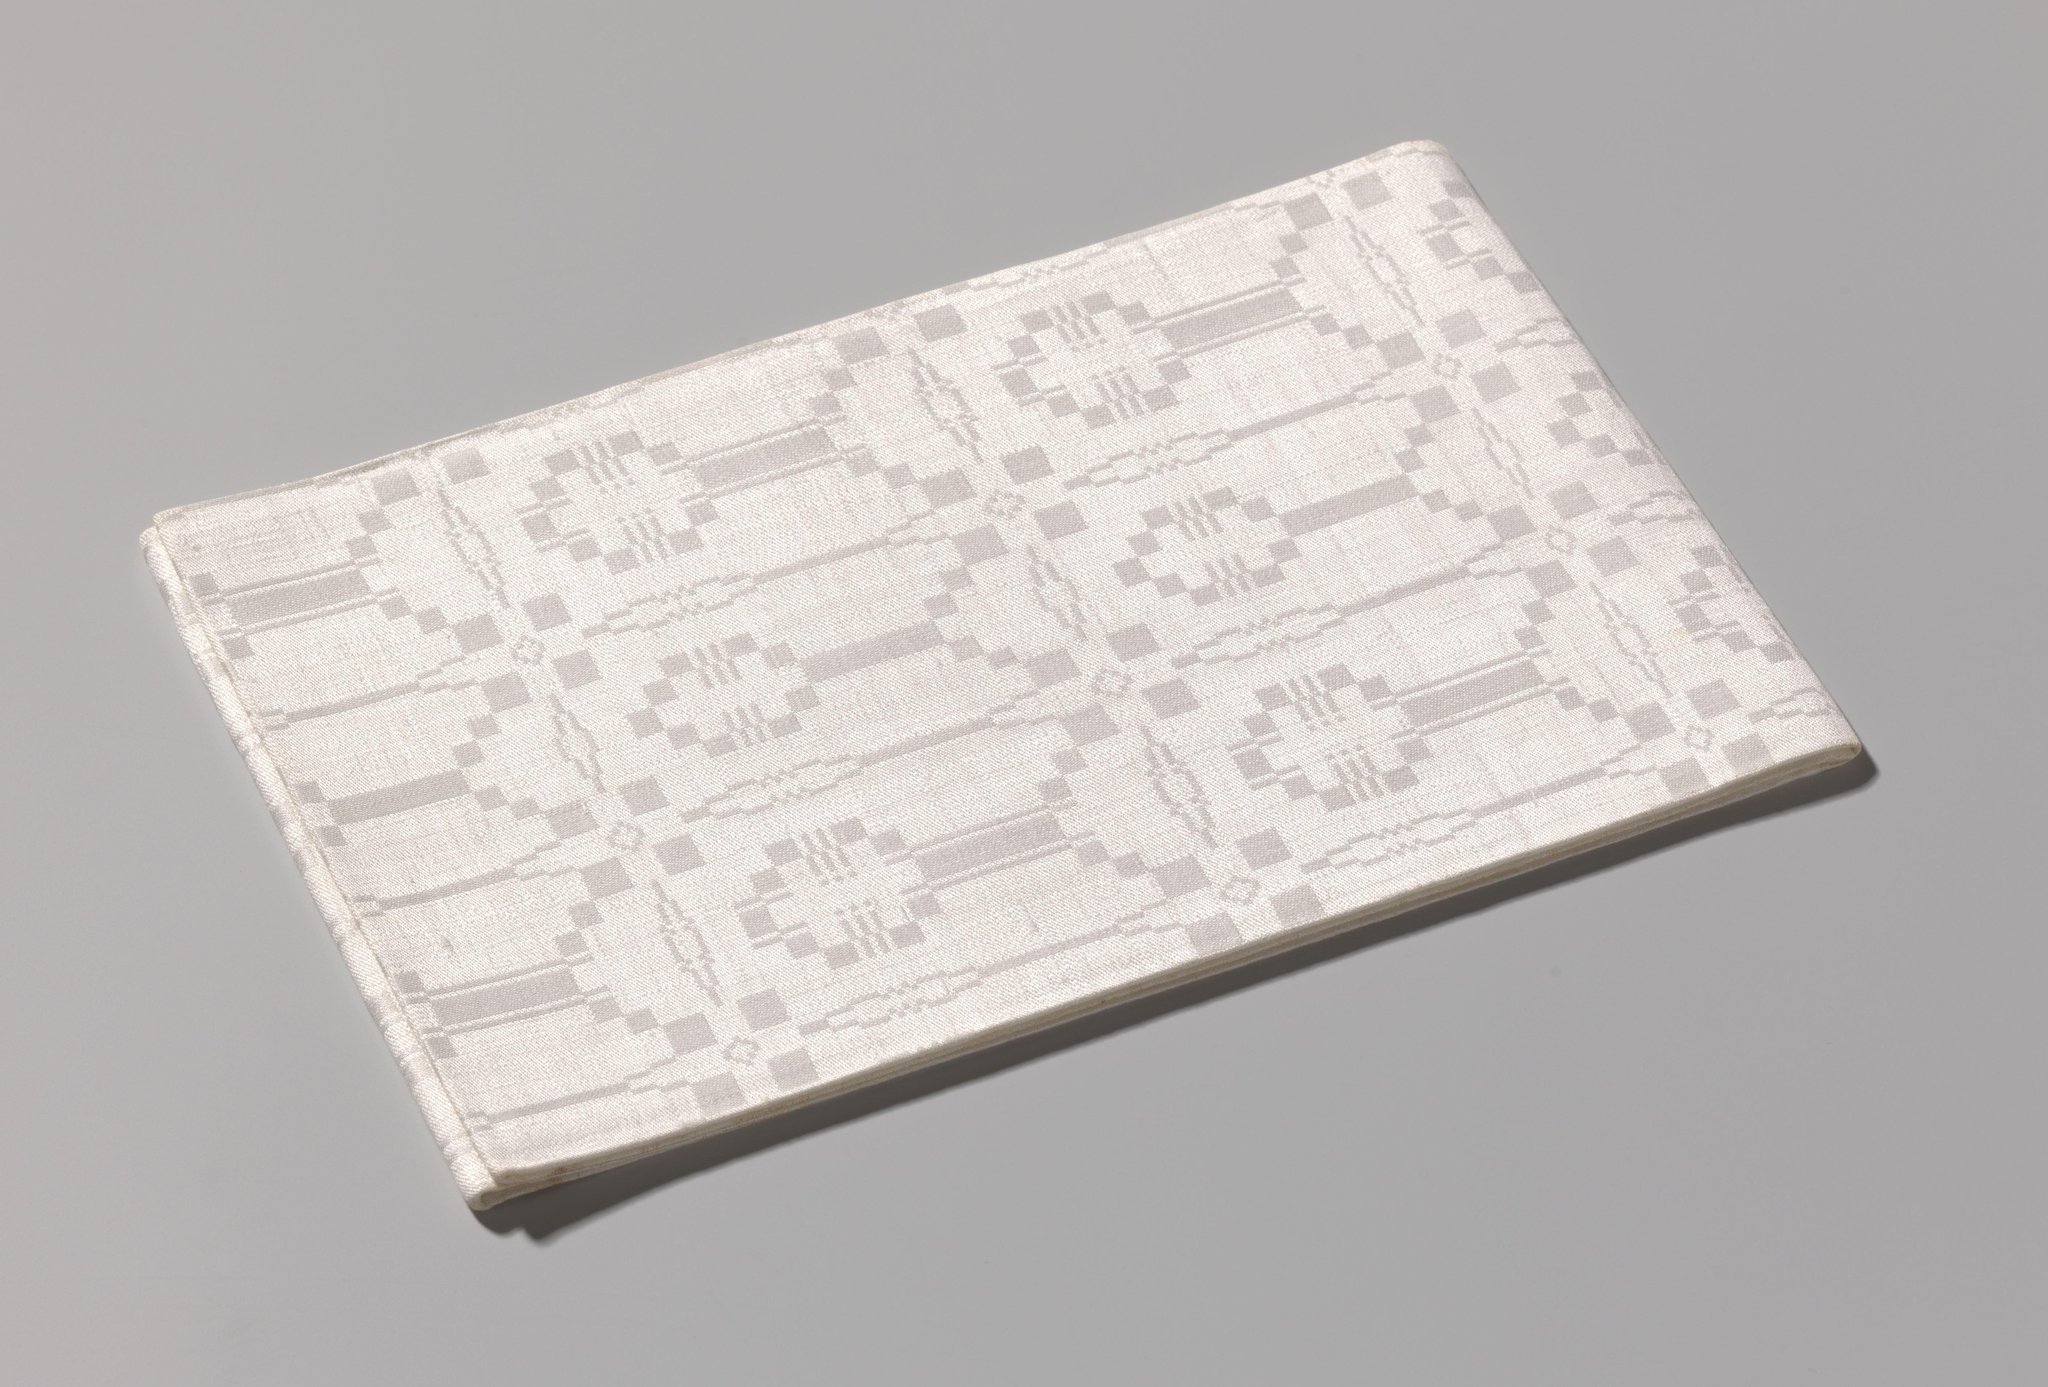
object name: napkin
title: Servet van linnen met pellenpatroon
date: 1726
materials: linen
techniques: peeled fabric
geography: northern netherlands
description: wit linnen servet met pellen patroon, merk GS 60 en 1727